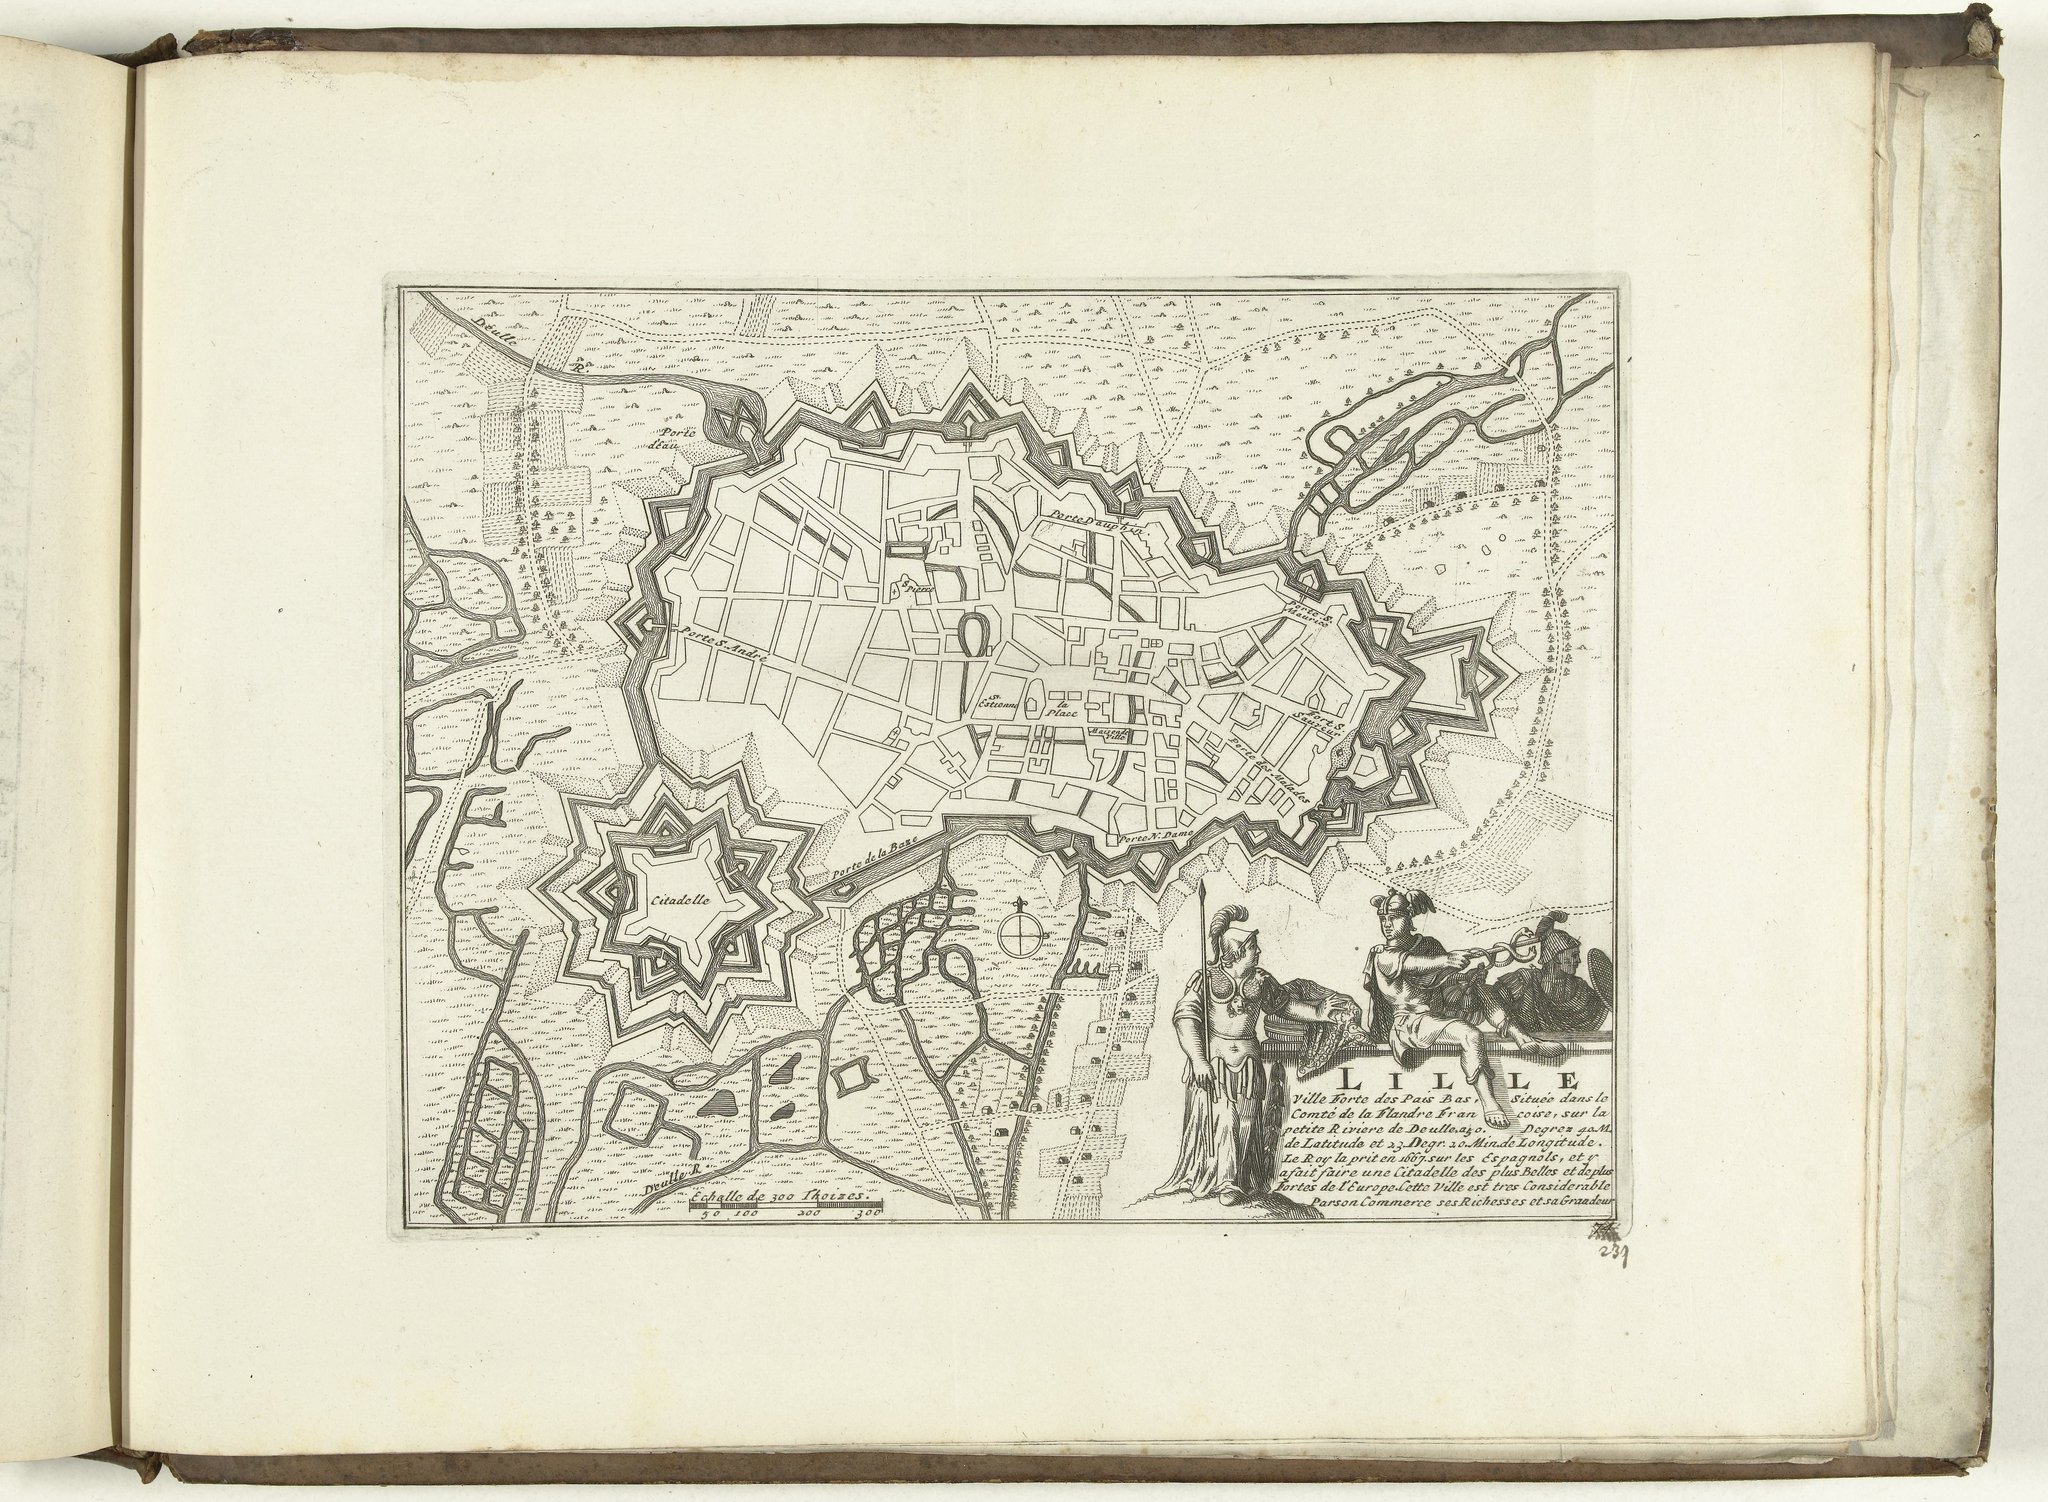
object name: print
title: Plattegrond van Lille, 1726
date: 1726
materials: paper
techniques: etching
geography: leiden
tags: fortress, maps of cities, lille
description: Plattegrond van de verdedigingswerken om de stad Lille (Rijssel). Plaat nr. 234 in deel X van het prentwerk: Les Forces de l'Europe, Asie, Afrique et Amerique ... Comme aussi les Cartes des Côtes de France et d'Espagne uit 1726, dit eerste deel met 238 met de hand genummerde platen van vermaarde sterke steden en vestingen in het kader van de Spaanse Successieoorlog 1701-1713. Voor het merendeel zijn deze platen gekopieerd naar de anonieme Franse platen van vermaarde sterke steden en vestingen: in Les forces de l'Europe en in: Le theatre de la guerre, dans les Pays-Bas, beide oorspronkelijk uitgegeven door Nicolas de Fer te Parijs (1693-1697) in het kader van de Negenjarige Oorlog. Titel en opschriften in het Frans. Rechtsonder het nummer 74 met de pen doorgekrast.